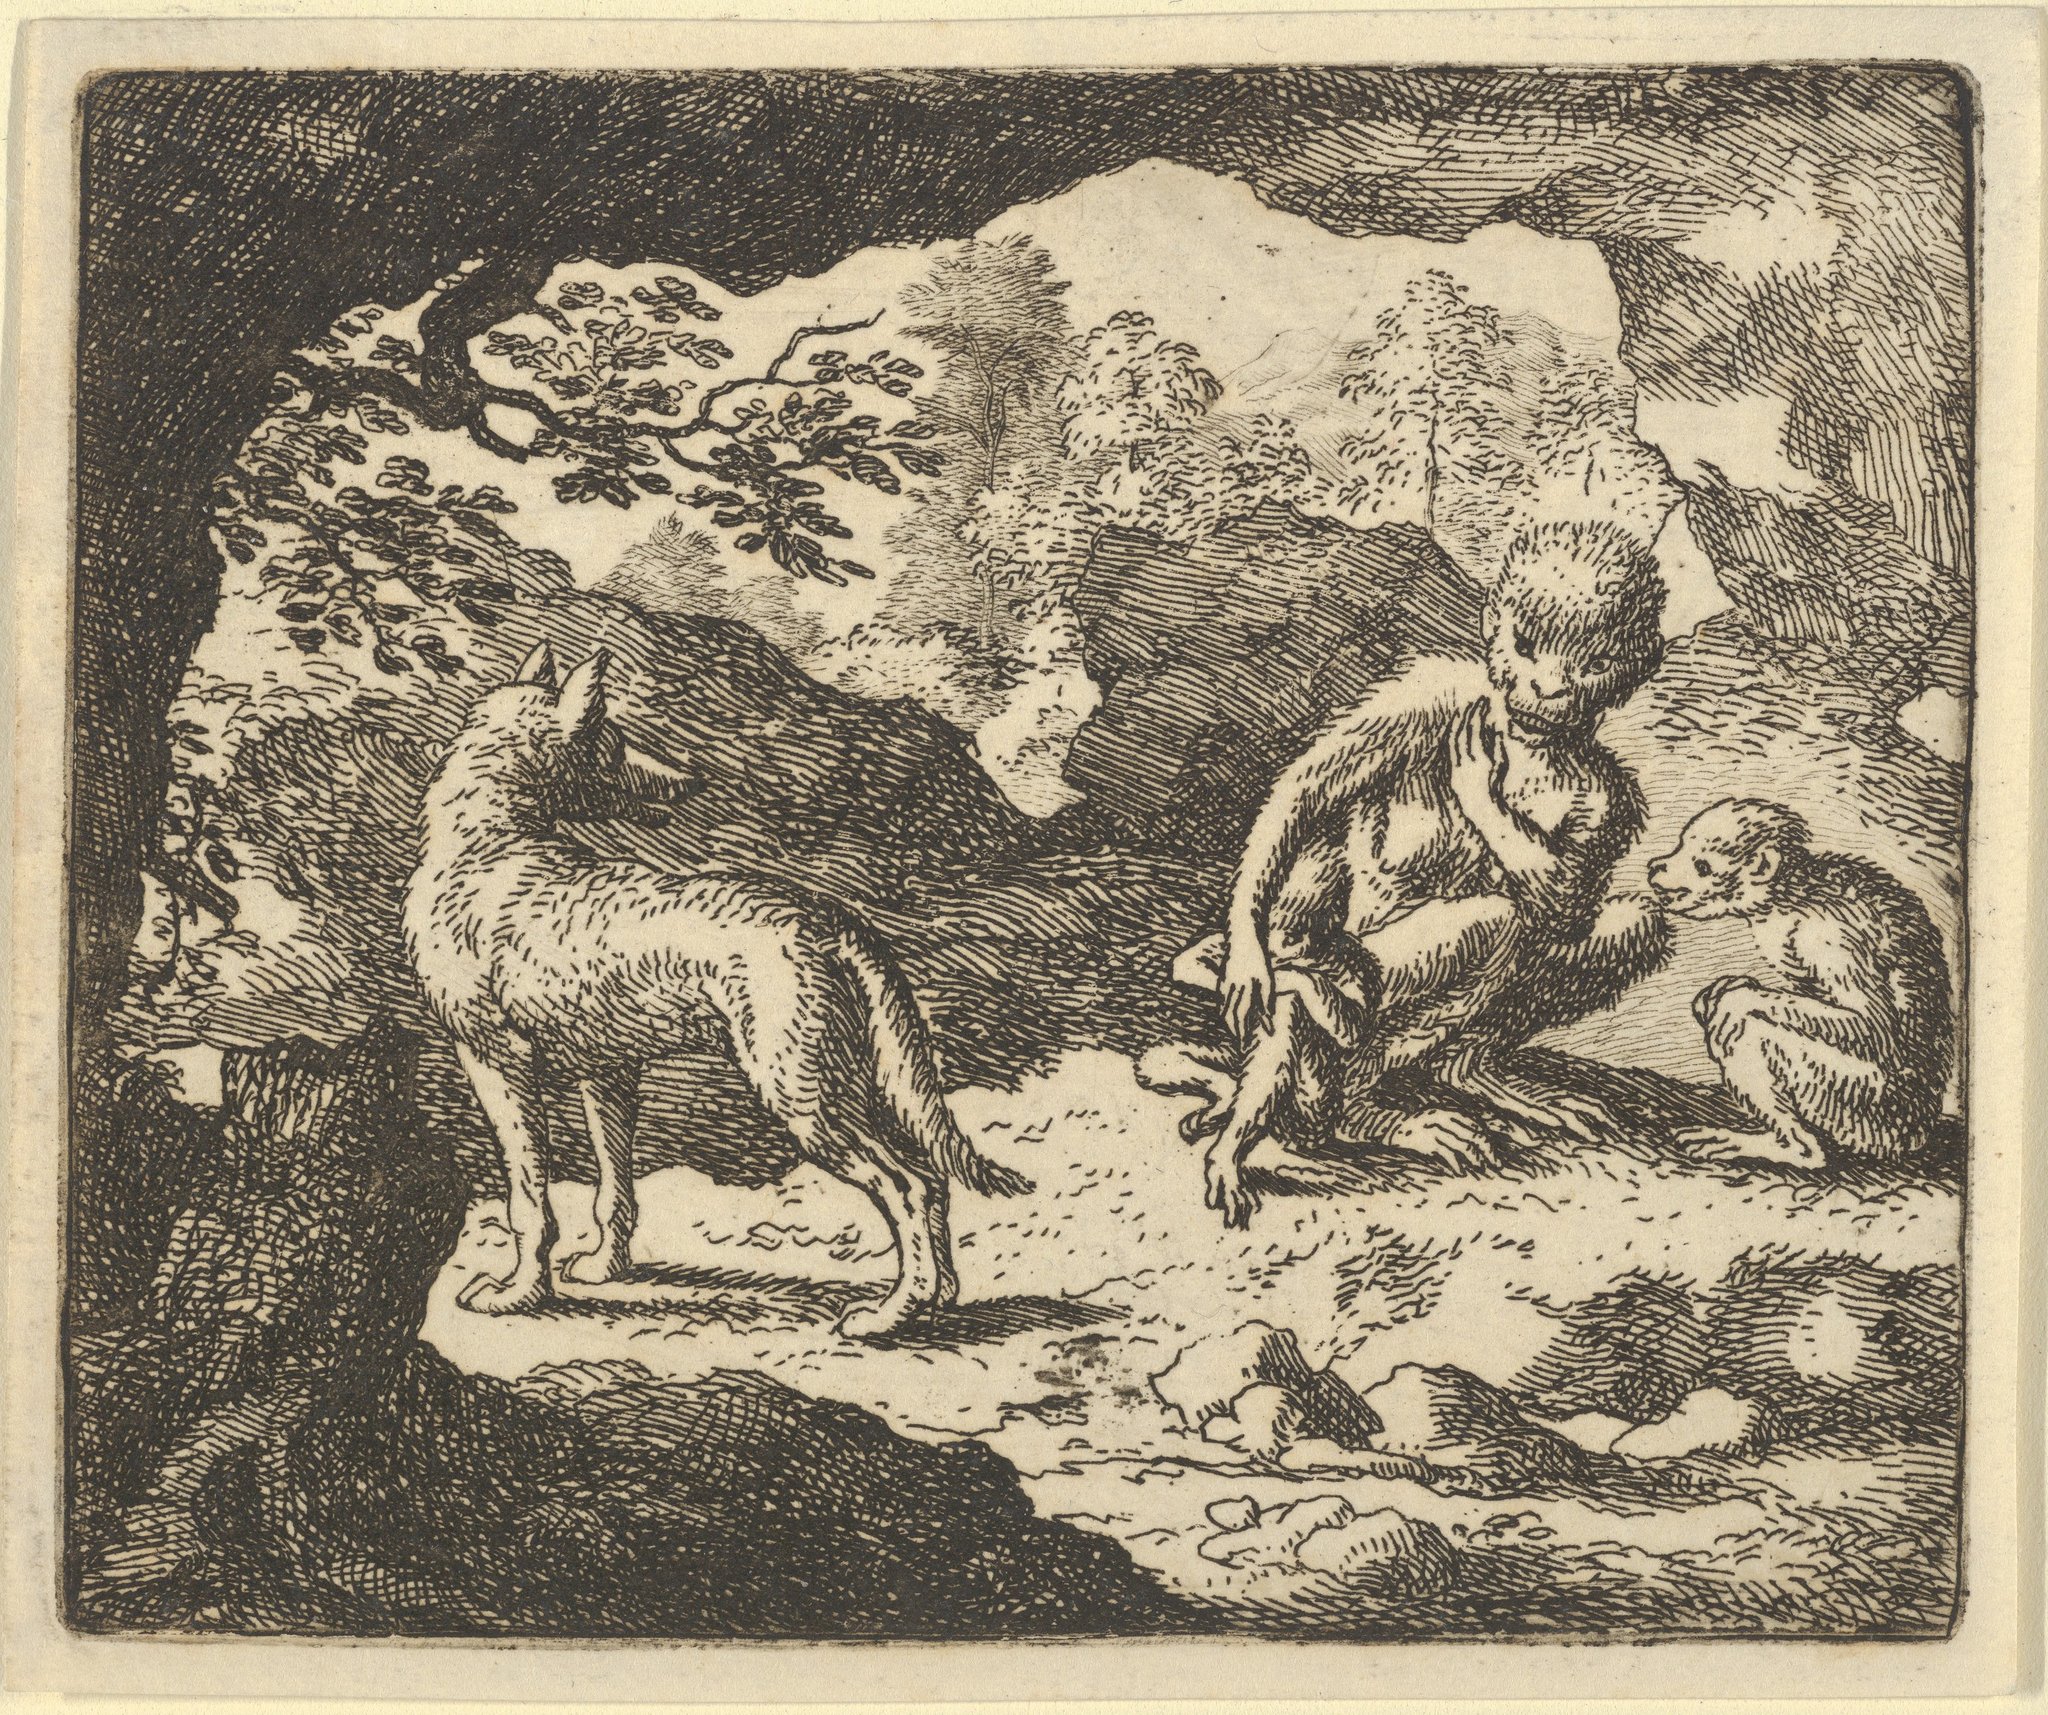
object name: print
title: The Wolf in in the She-Monkey's Cave Where the Renard Convinced Him to Enter in Order to Make Fun of Him from Hendrick van Alcmar's Renard The Fox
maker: allart van everdingen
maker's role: artist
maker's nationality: dutch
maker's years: 1621-1675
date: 1650-1675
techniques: engraving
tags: animals,monkeys,caves